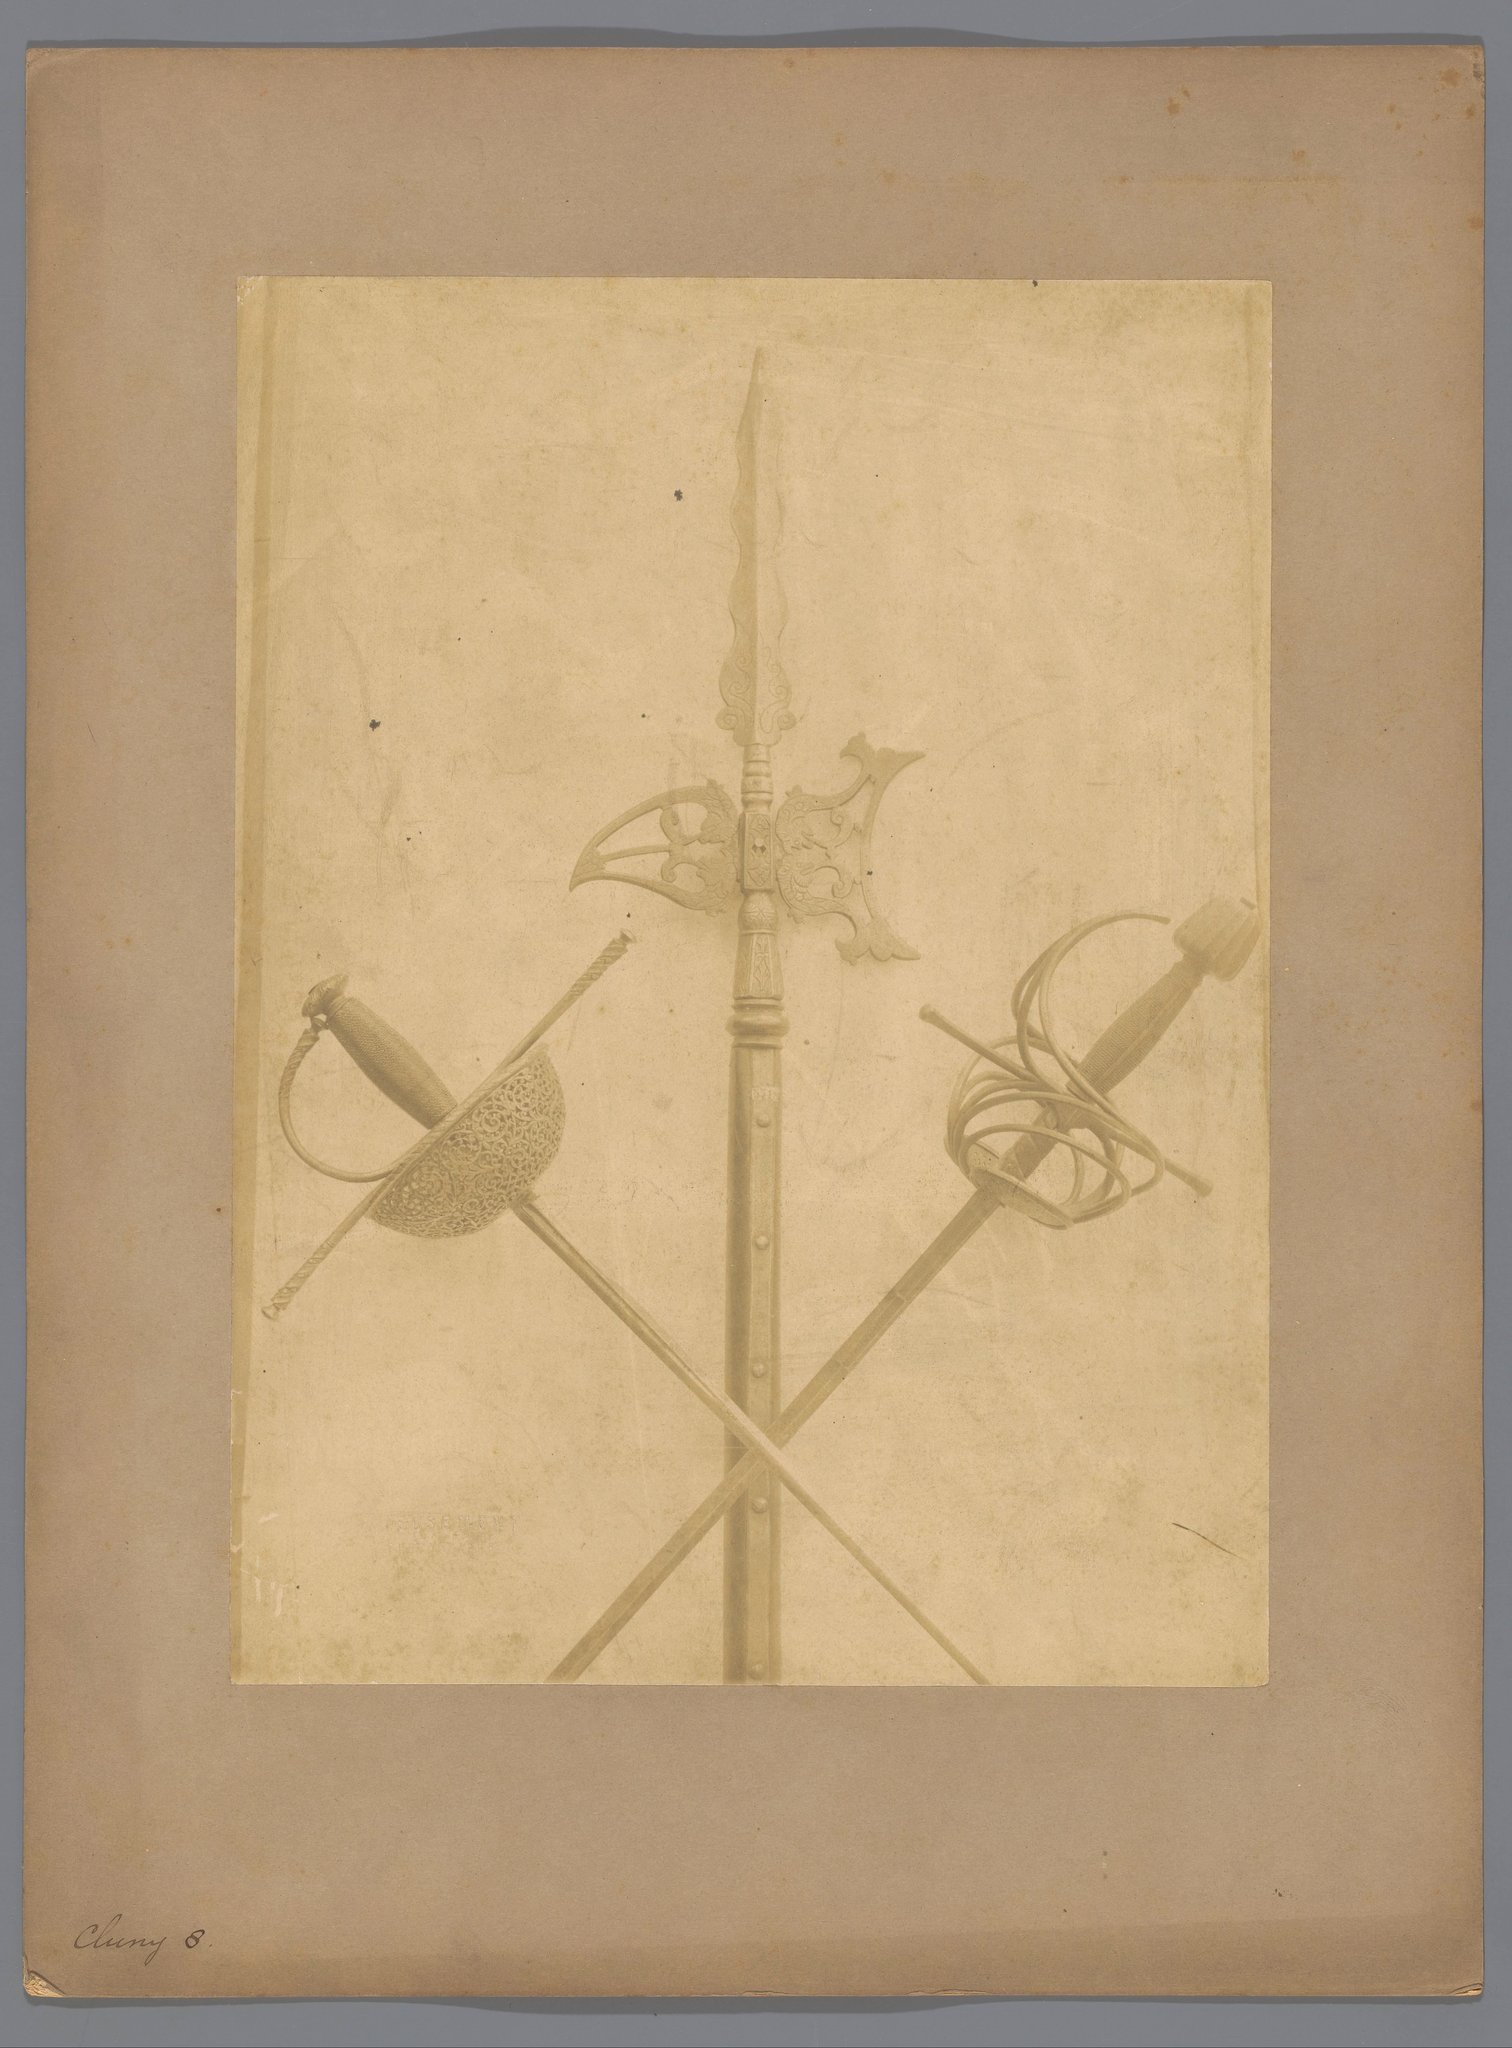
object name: photograph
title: Hellebaard met twee zwaarden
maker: séraphin-médéric mieusement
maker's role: fotograaf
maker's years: 1840-1905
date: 1850-1900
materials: cardboard, photographic support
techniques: albumen print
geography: paris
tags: hacking and thrusting weapons: sword, helved weapons, polearms (for striking, hacking, thrusting): halberd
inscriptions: number: ‘Cluny 8’, workshop stamp: ‘Mieusement/ Photographe’, collector's mark: ‘Rijks-normaalschool voor teekenonderwijzers Amsterdam’ Lugt 3937